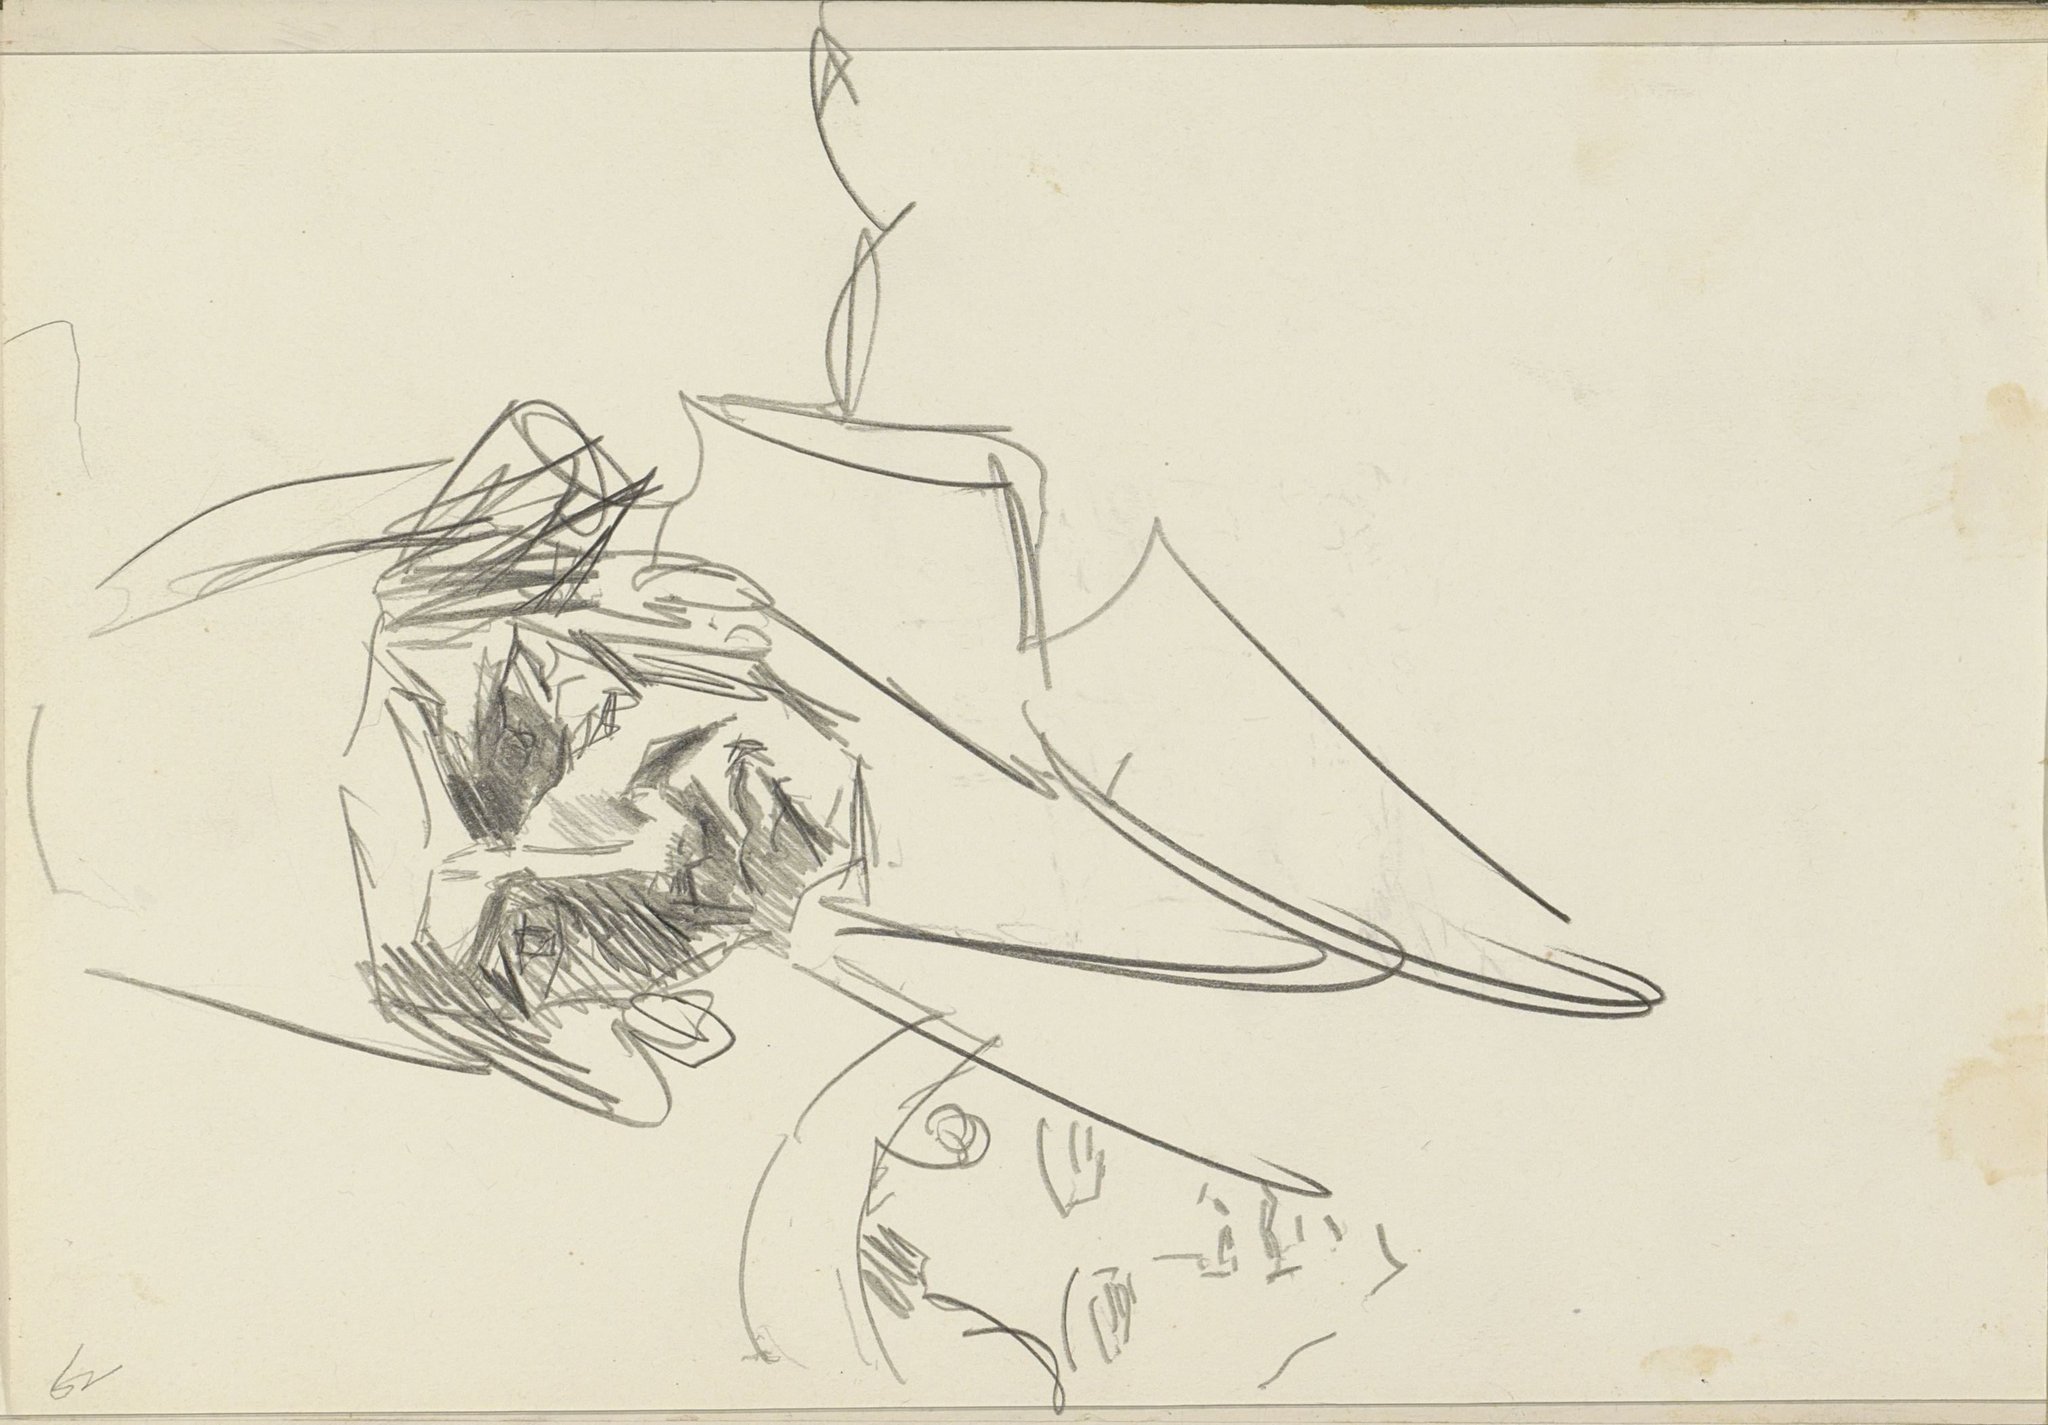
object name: sketchbook leaf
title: Twee figuurstudies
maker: isaac israels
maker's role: draughtsman, painter, print maker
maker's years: 1865-1934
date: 1875-1934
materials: paper, pencil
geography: the hague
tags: adult woman, stage costume, adult man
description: Mogelijk een verklede man en vrouw. Blad 16 verso uit schetsboek XXVIII met 17 bladen.